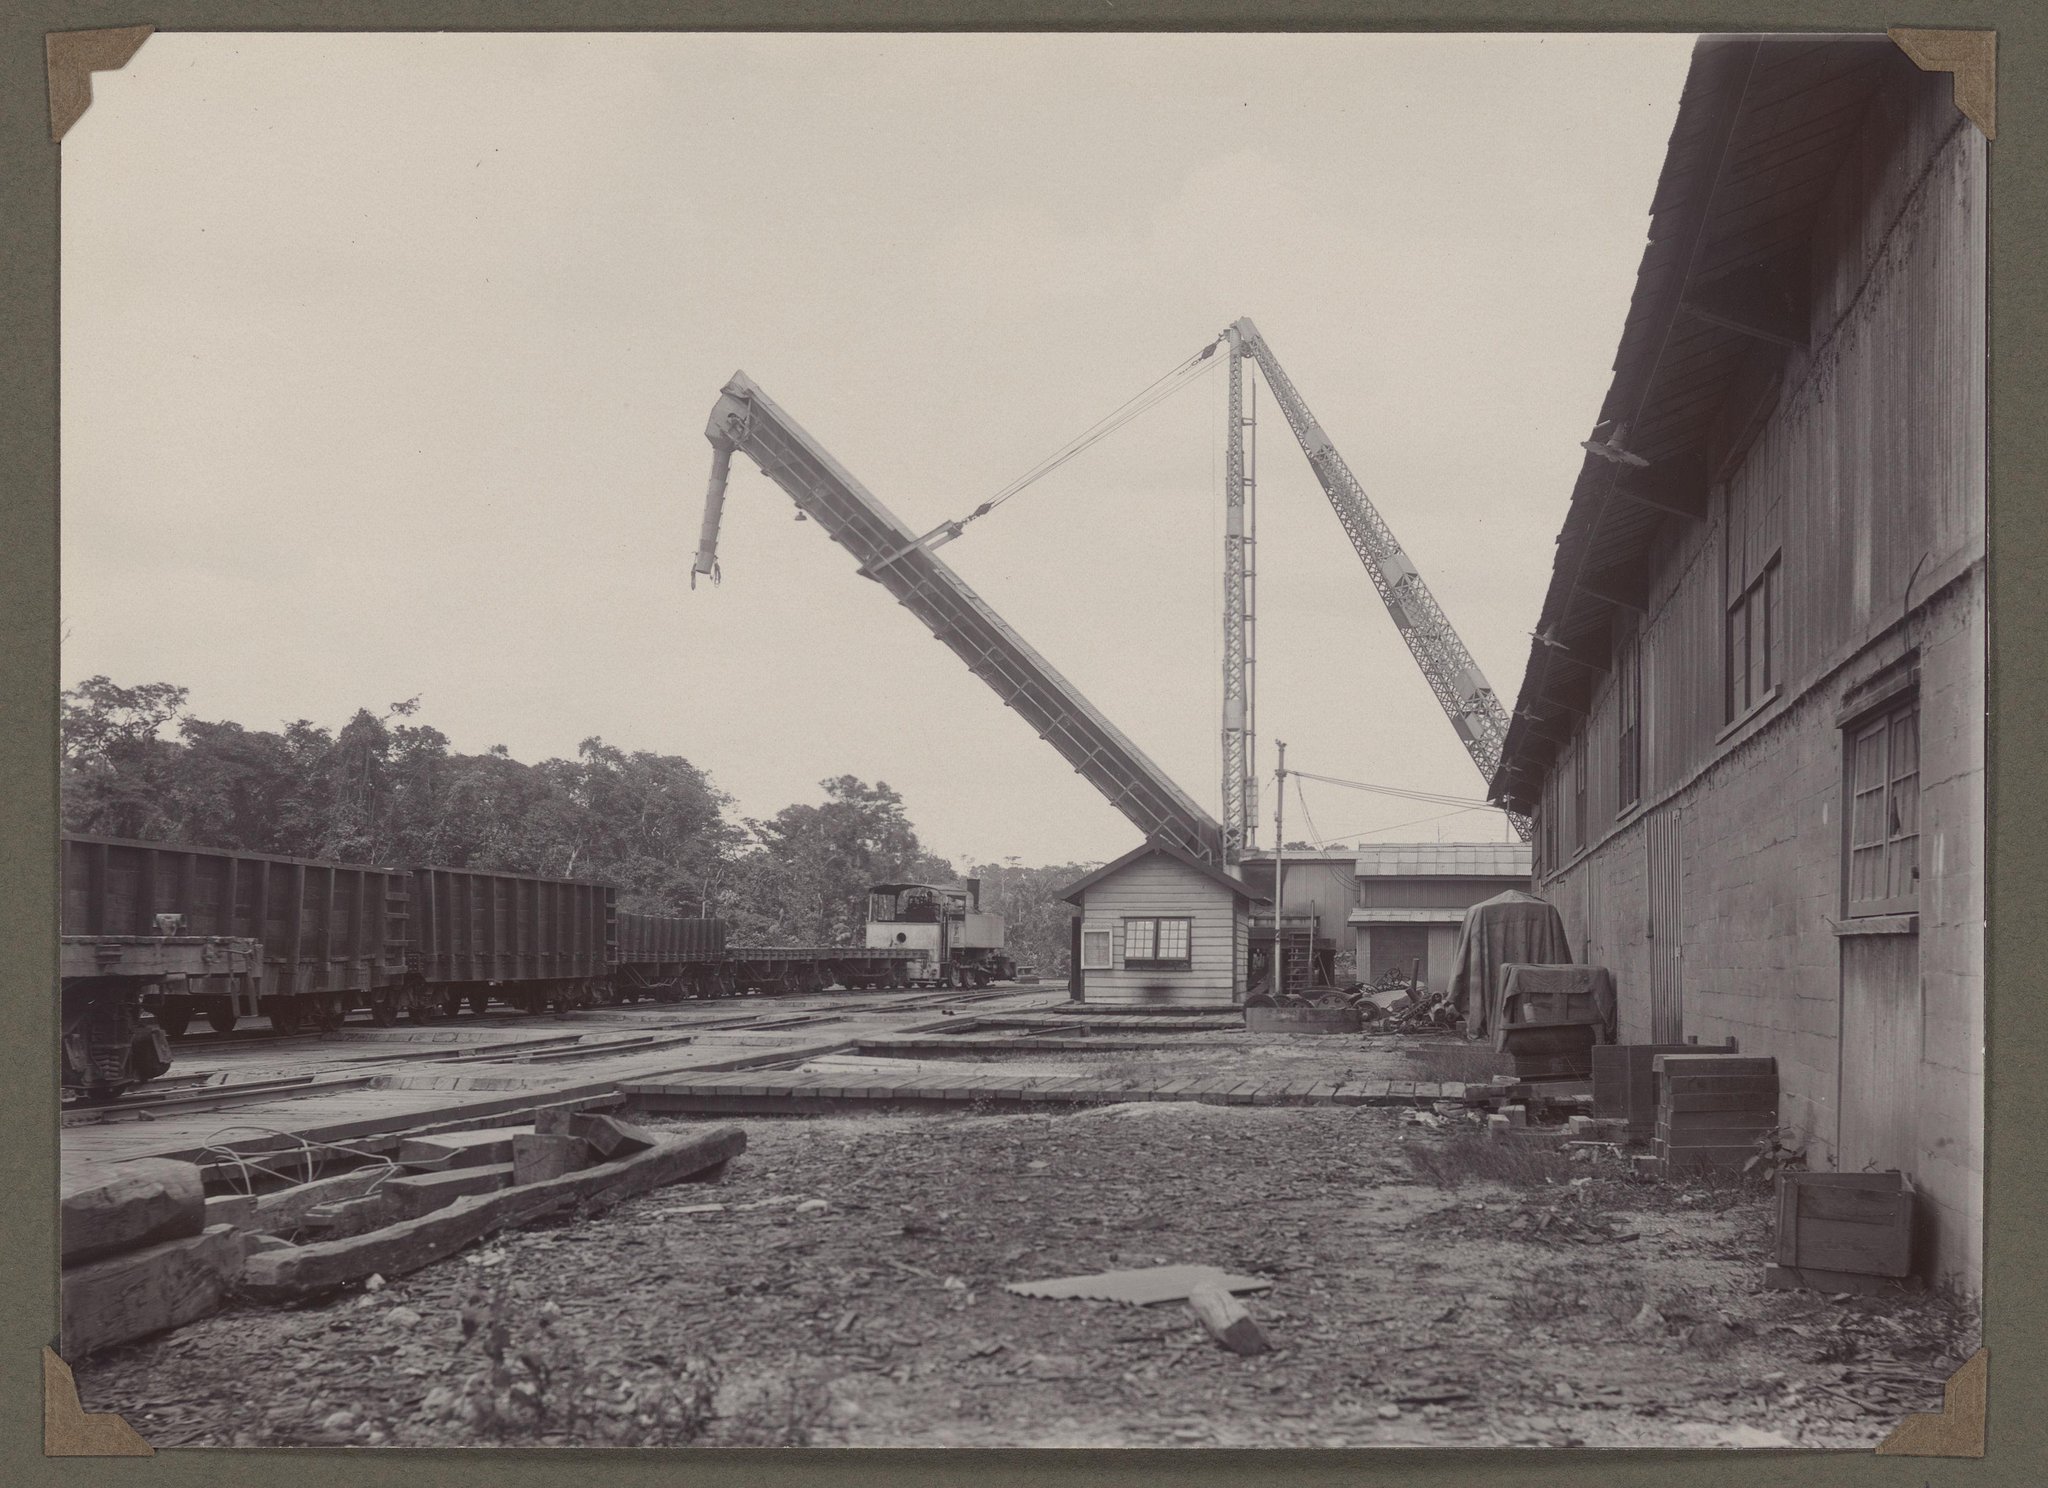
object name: photograph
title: Mijn en fabriek te Moengo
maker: Anonymous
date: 1925-1927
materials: photographic support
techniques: photography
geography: suriname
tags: jetten, familie, moengo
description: Spoorbaan met de mijn en fabriek te Moengo. Foto op een bladzijde van een los albumblad. Onderdeel van het ensemble met foto's van de familie van ingenieur Jetten in de mijnbouwstad Moengo in Suriname.